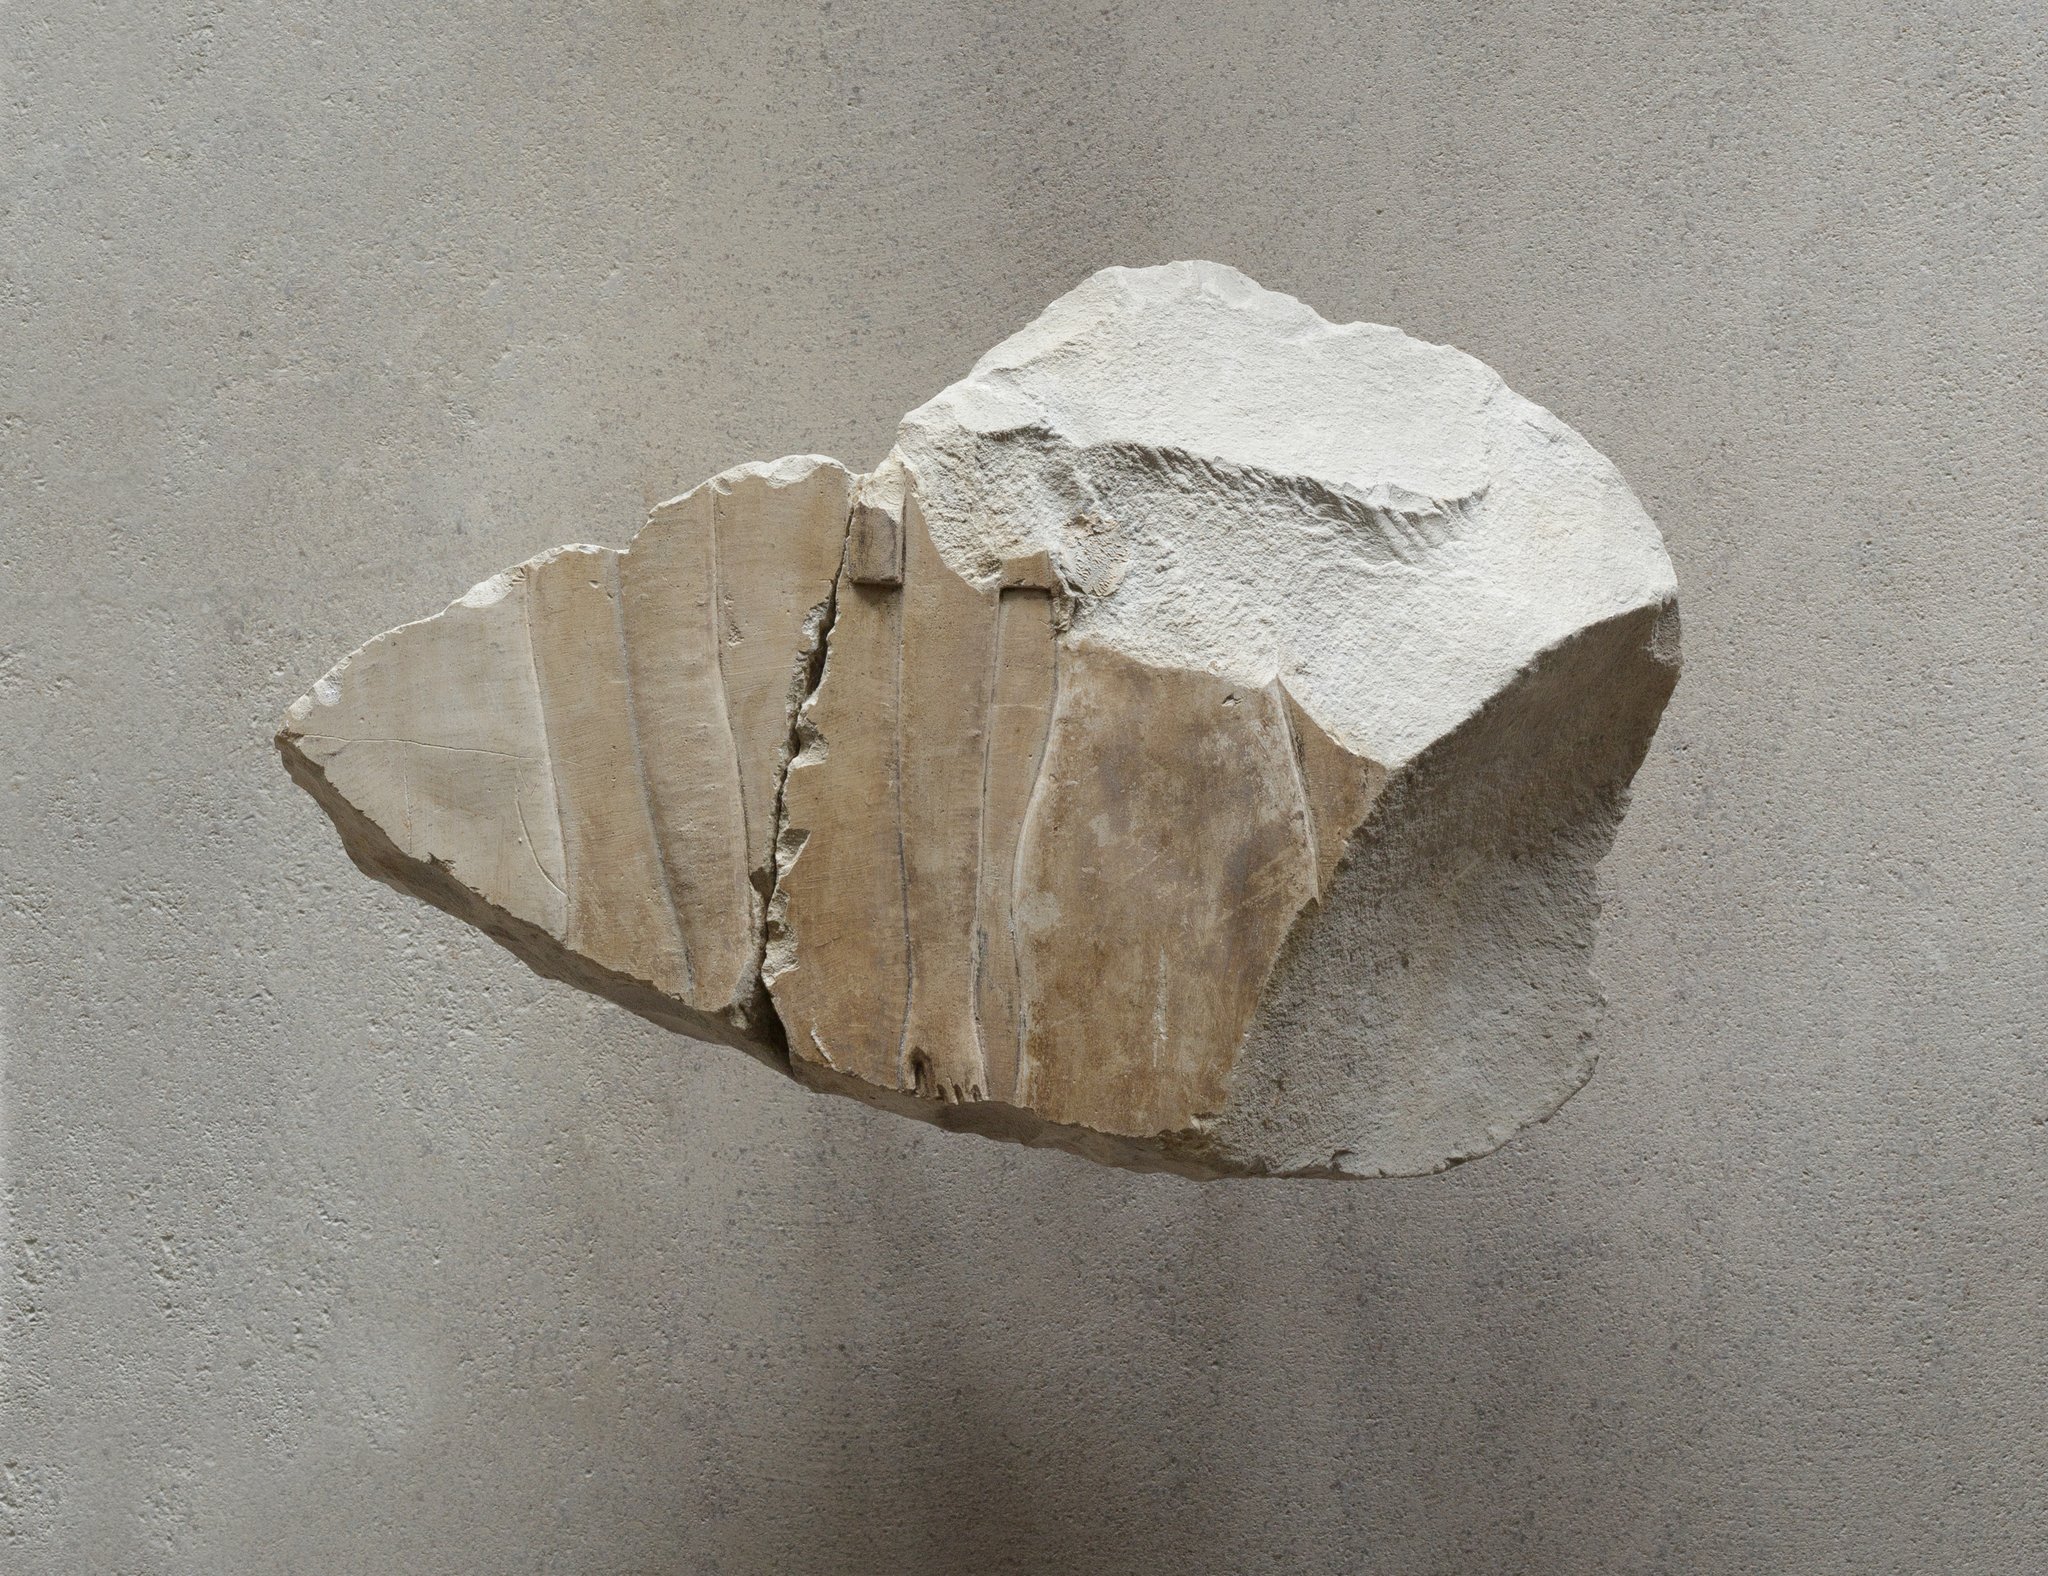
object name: relief, part of female attendant, neferu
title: Relief from the tomb of Queen Neferu: two female attendants (see 26.3.353-1)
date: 2051-2030 BCE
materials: limestone, paint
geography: egypt